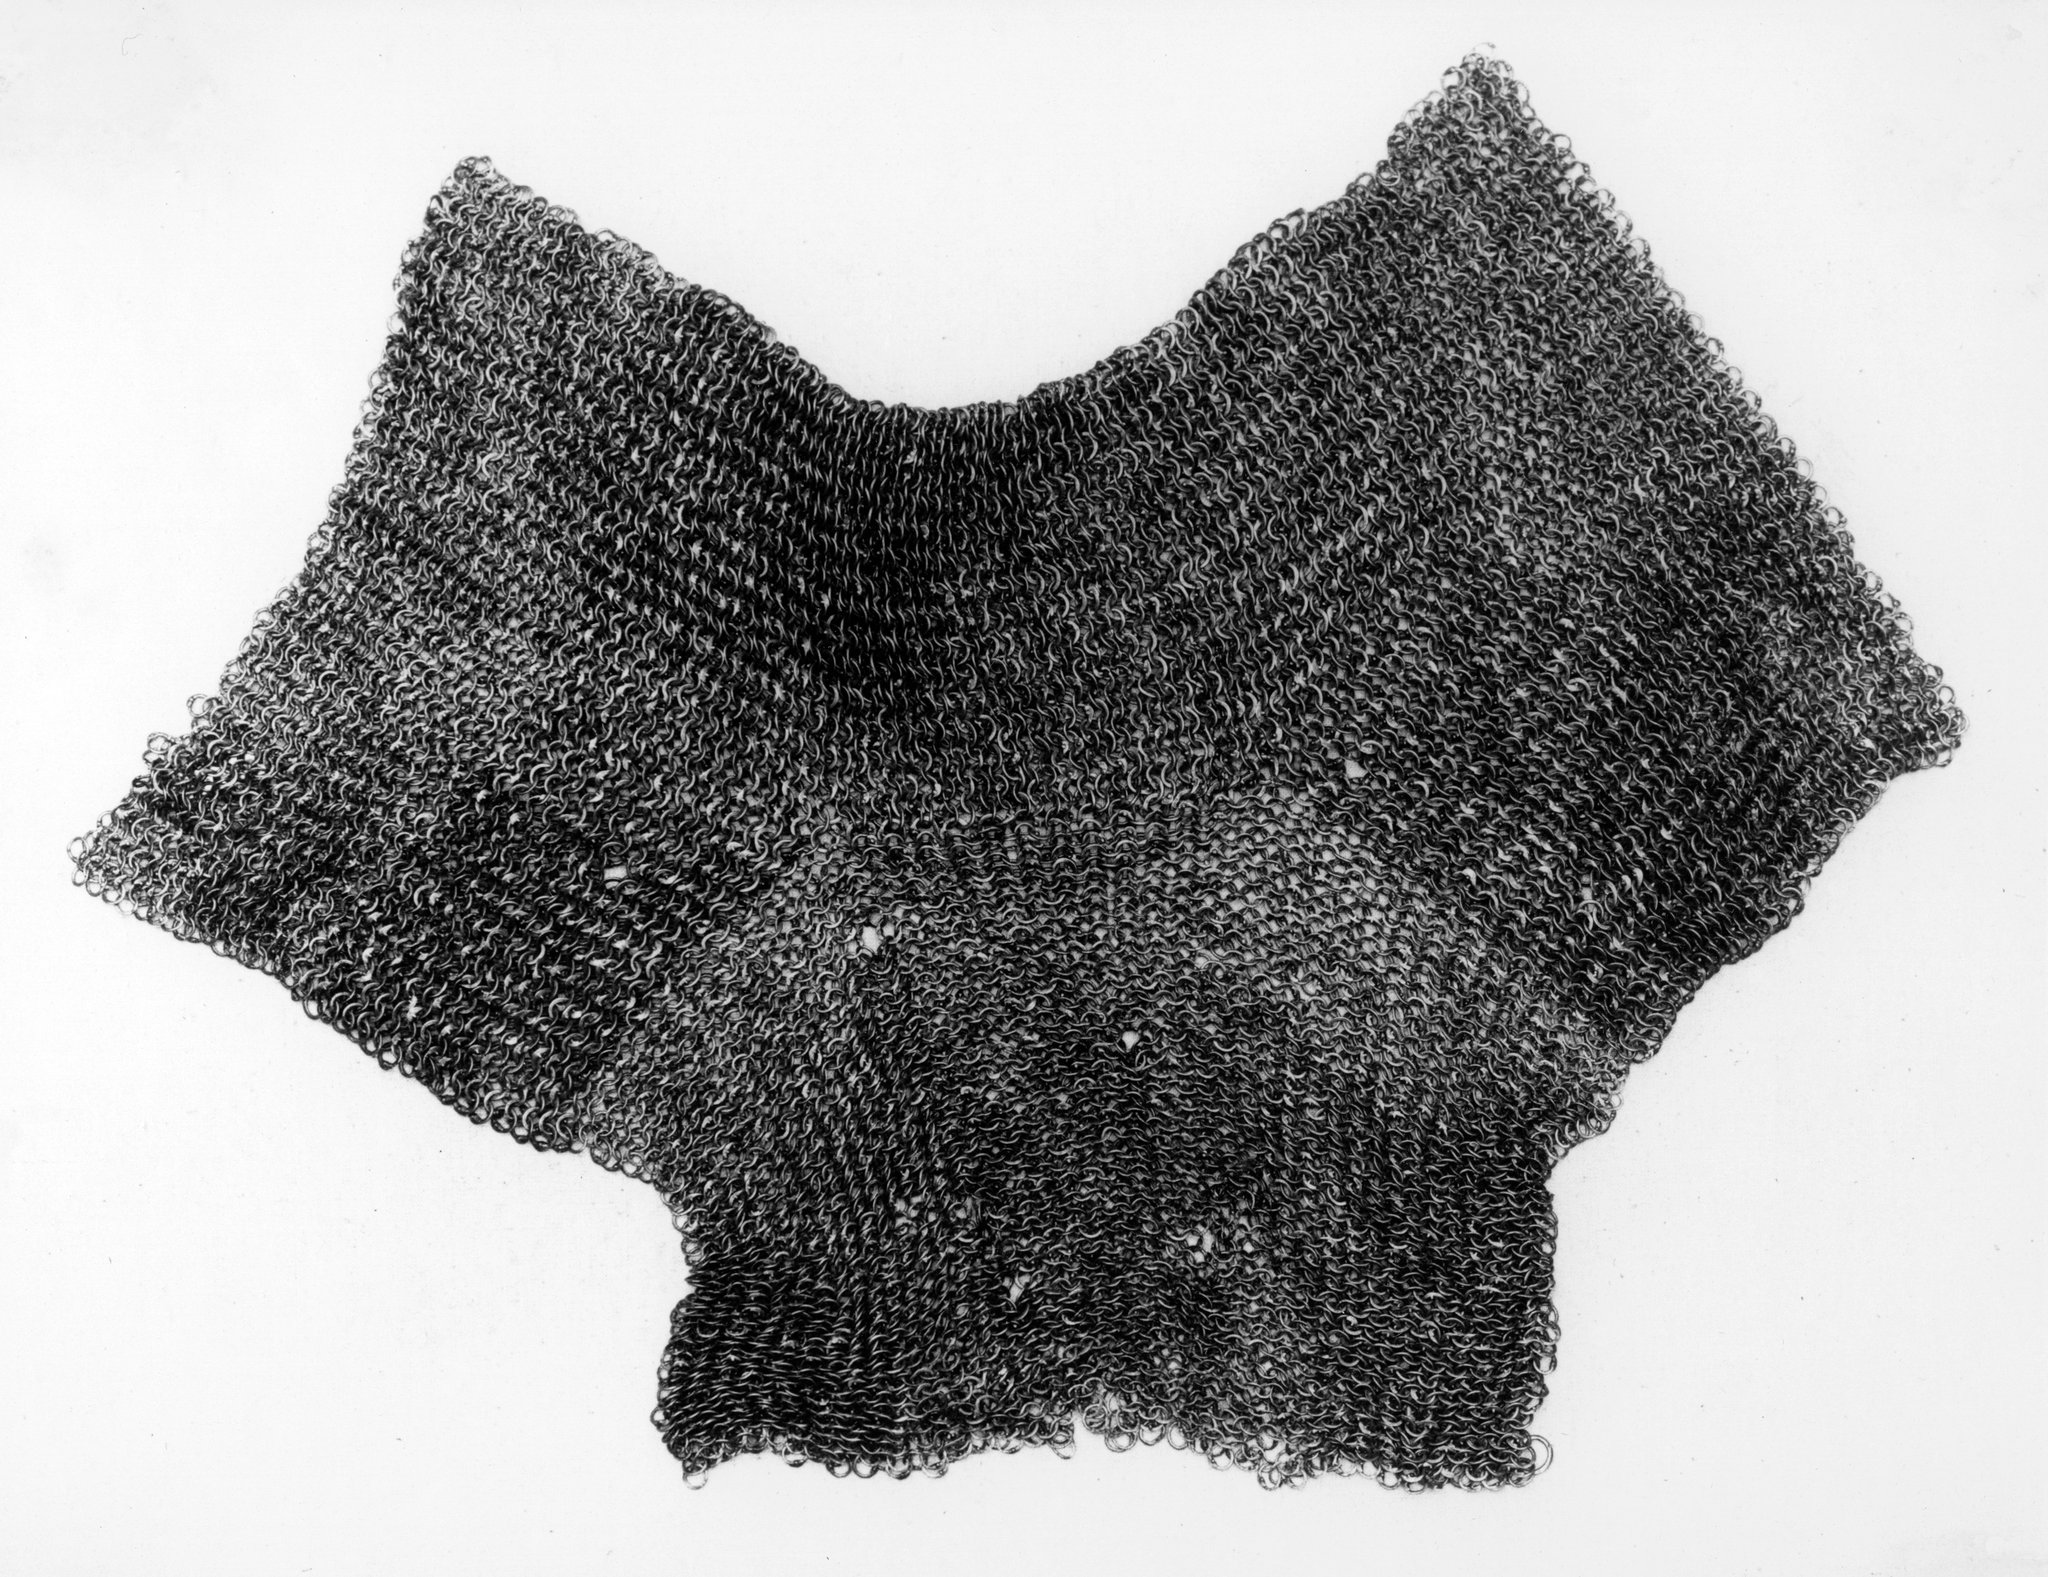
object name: armpit defense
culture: german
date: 1501-1600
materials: steel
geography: germany